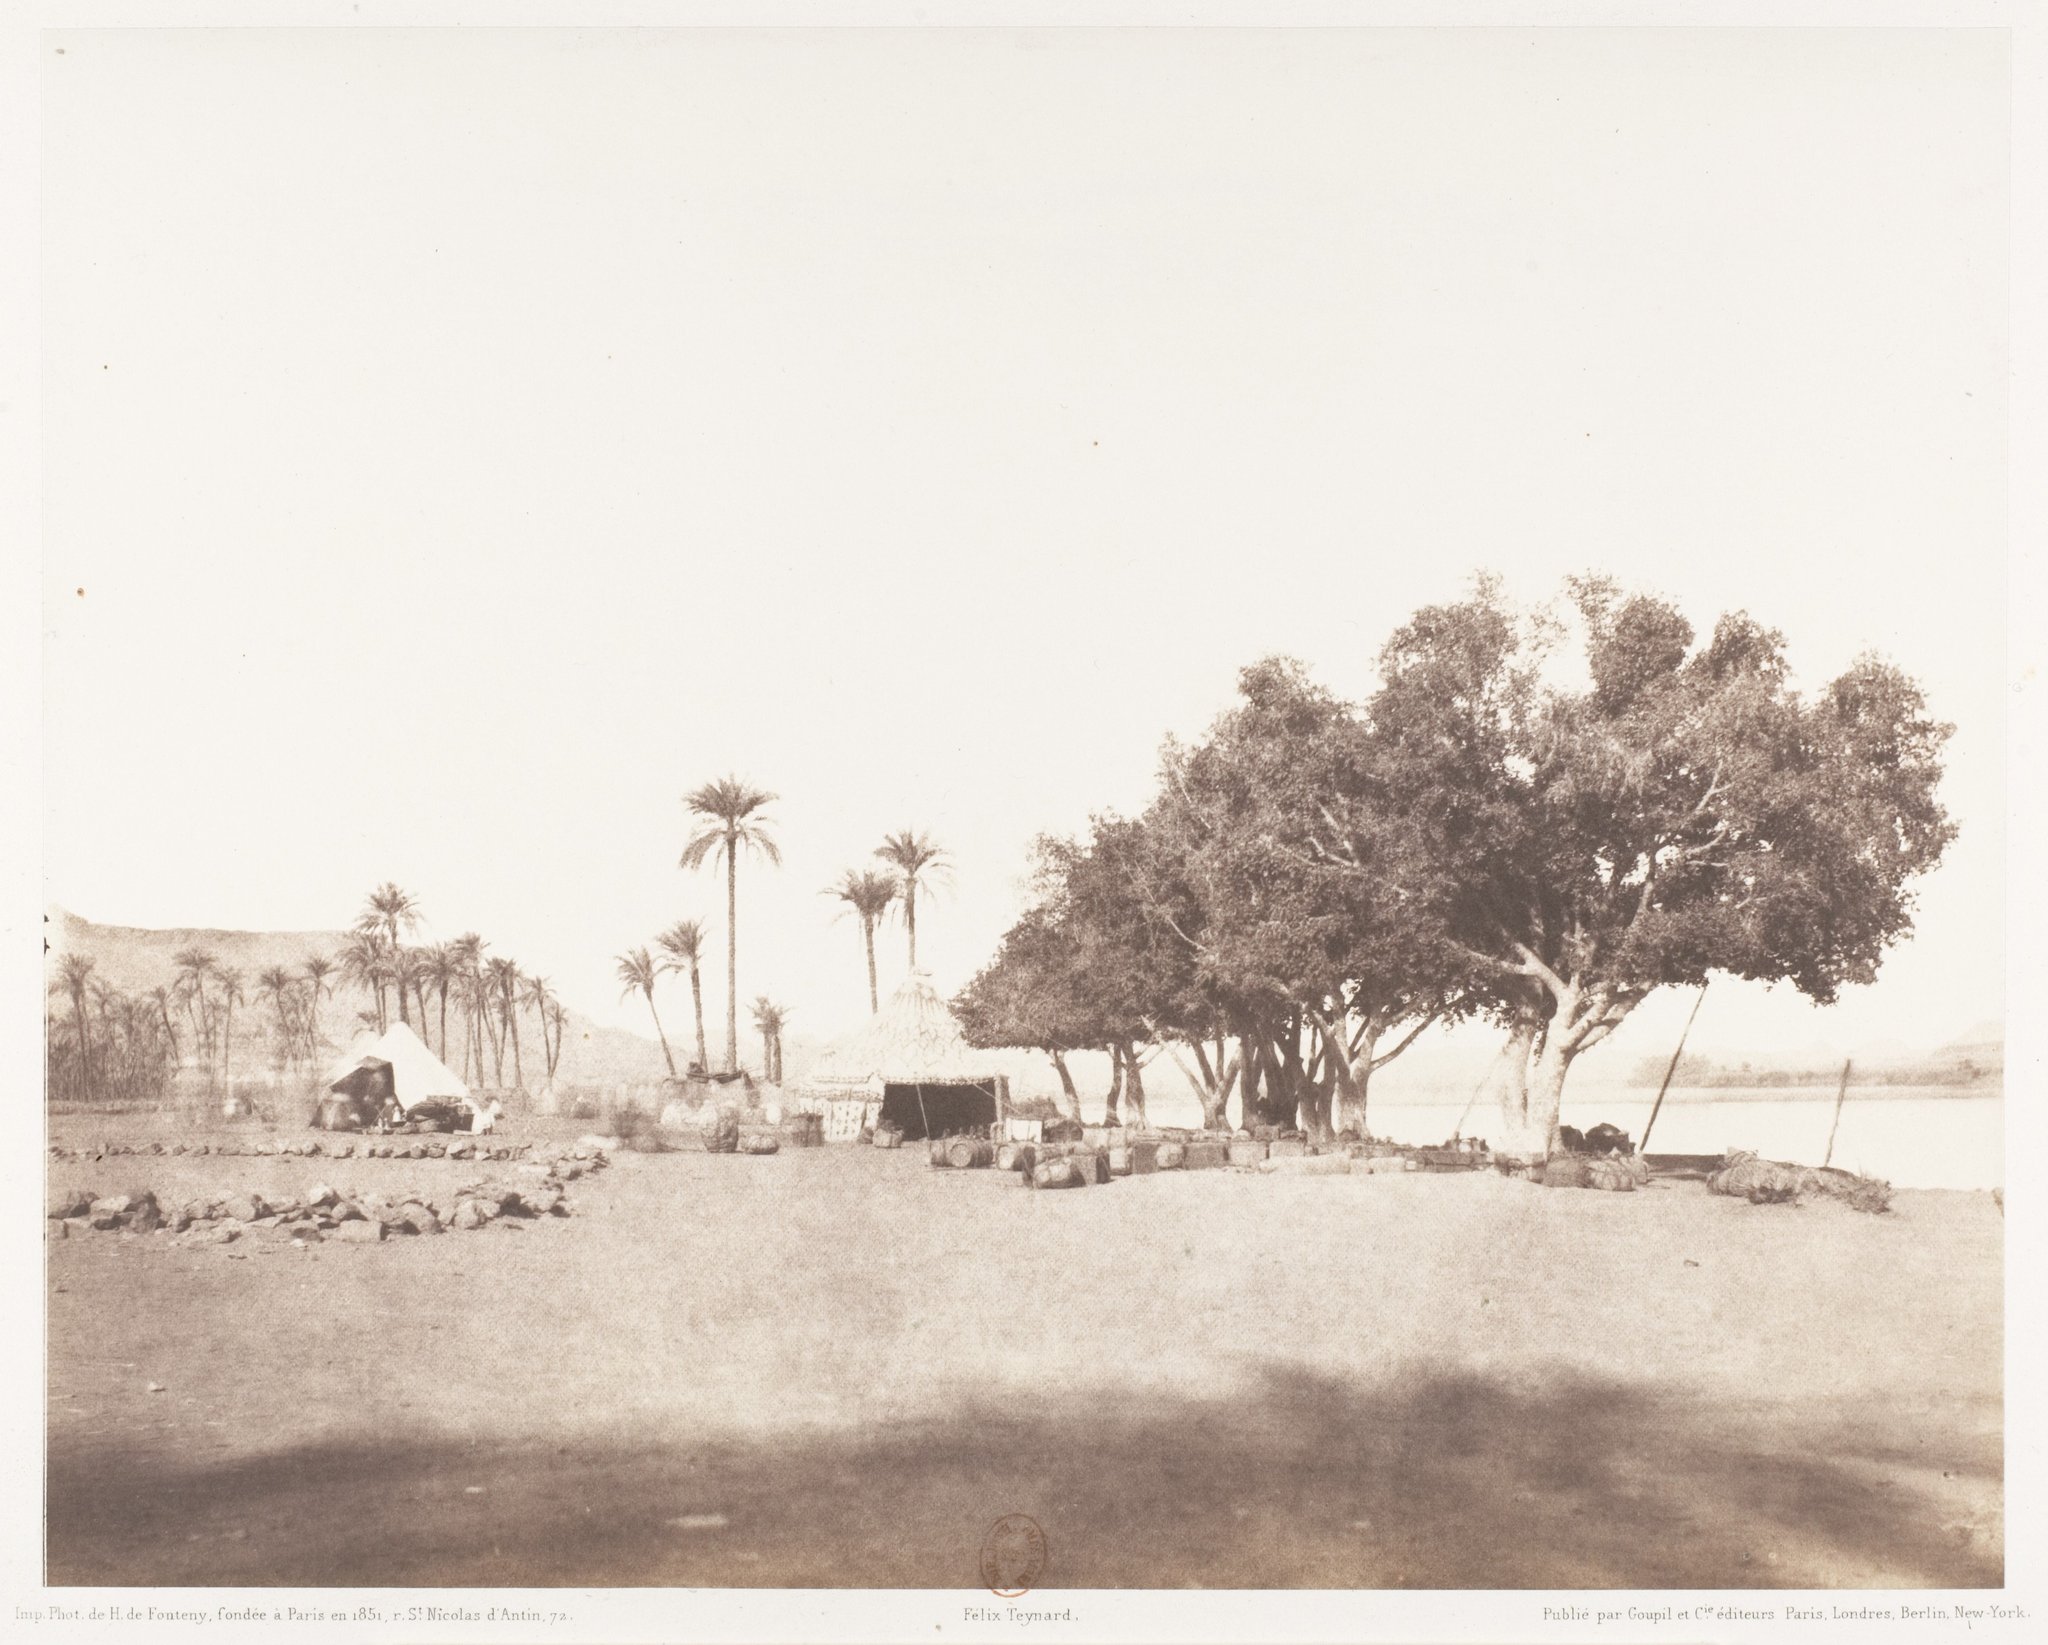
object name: photograph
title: Korósko, Sycomores et Campement d'une Caravane pour le Sennâr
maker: félix teynard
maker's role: artist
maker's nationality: french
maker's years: 1817-1892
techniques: paper negative, salted paper print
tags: tents,landscapes